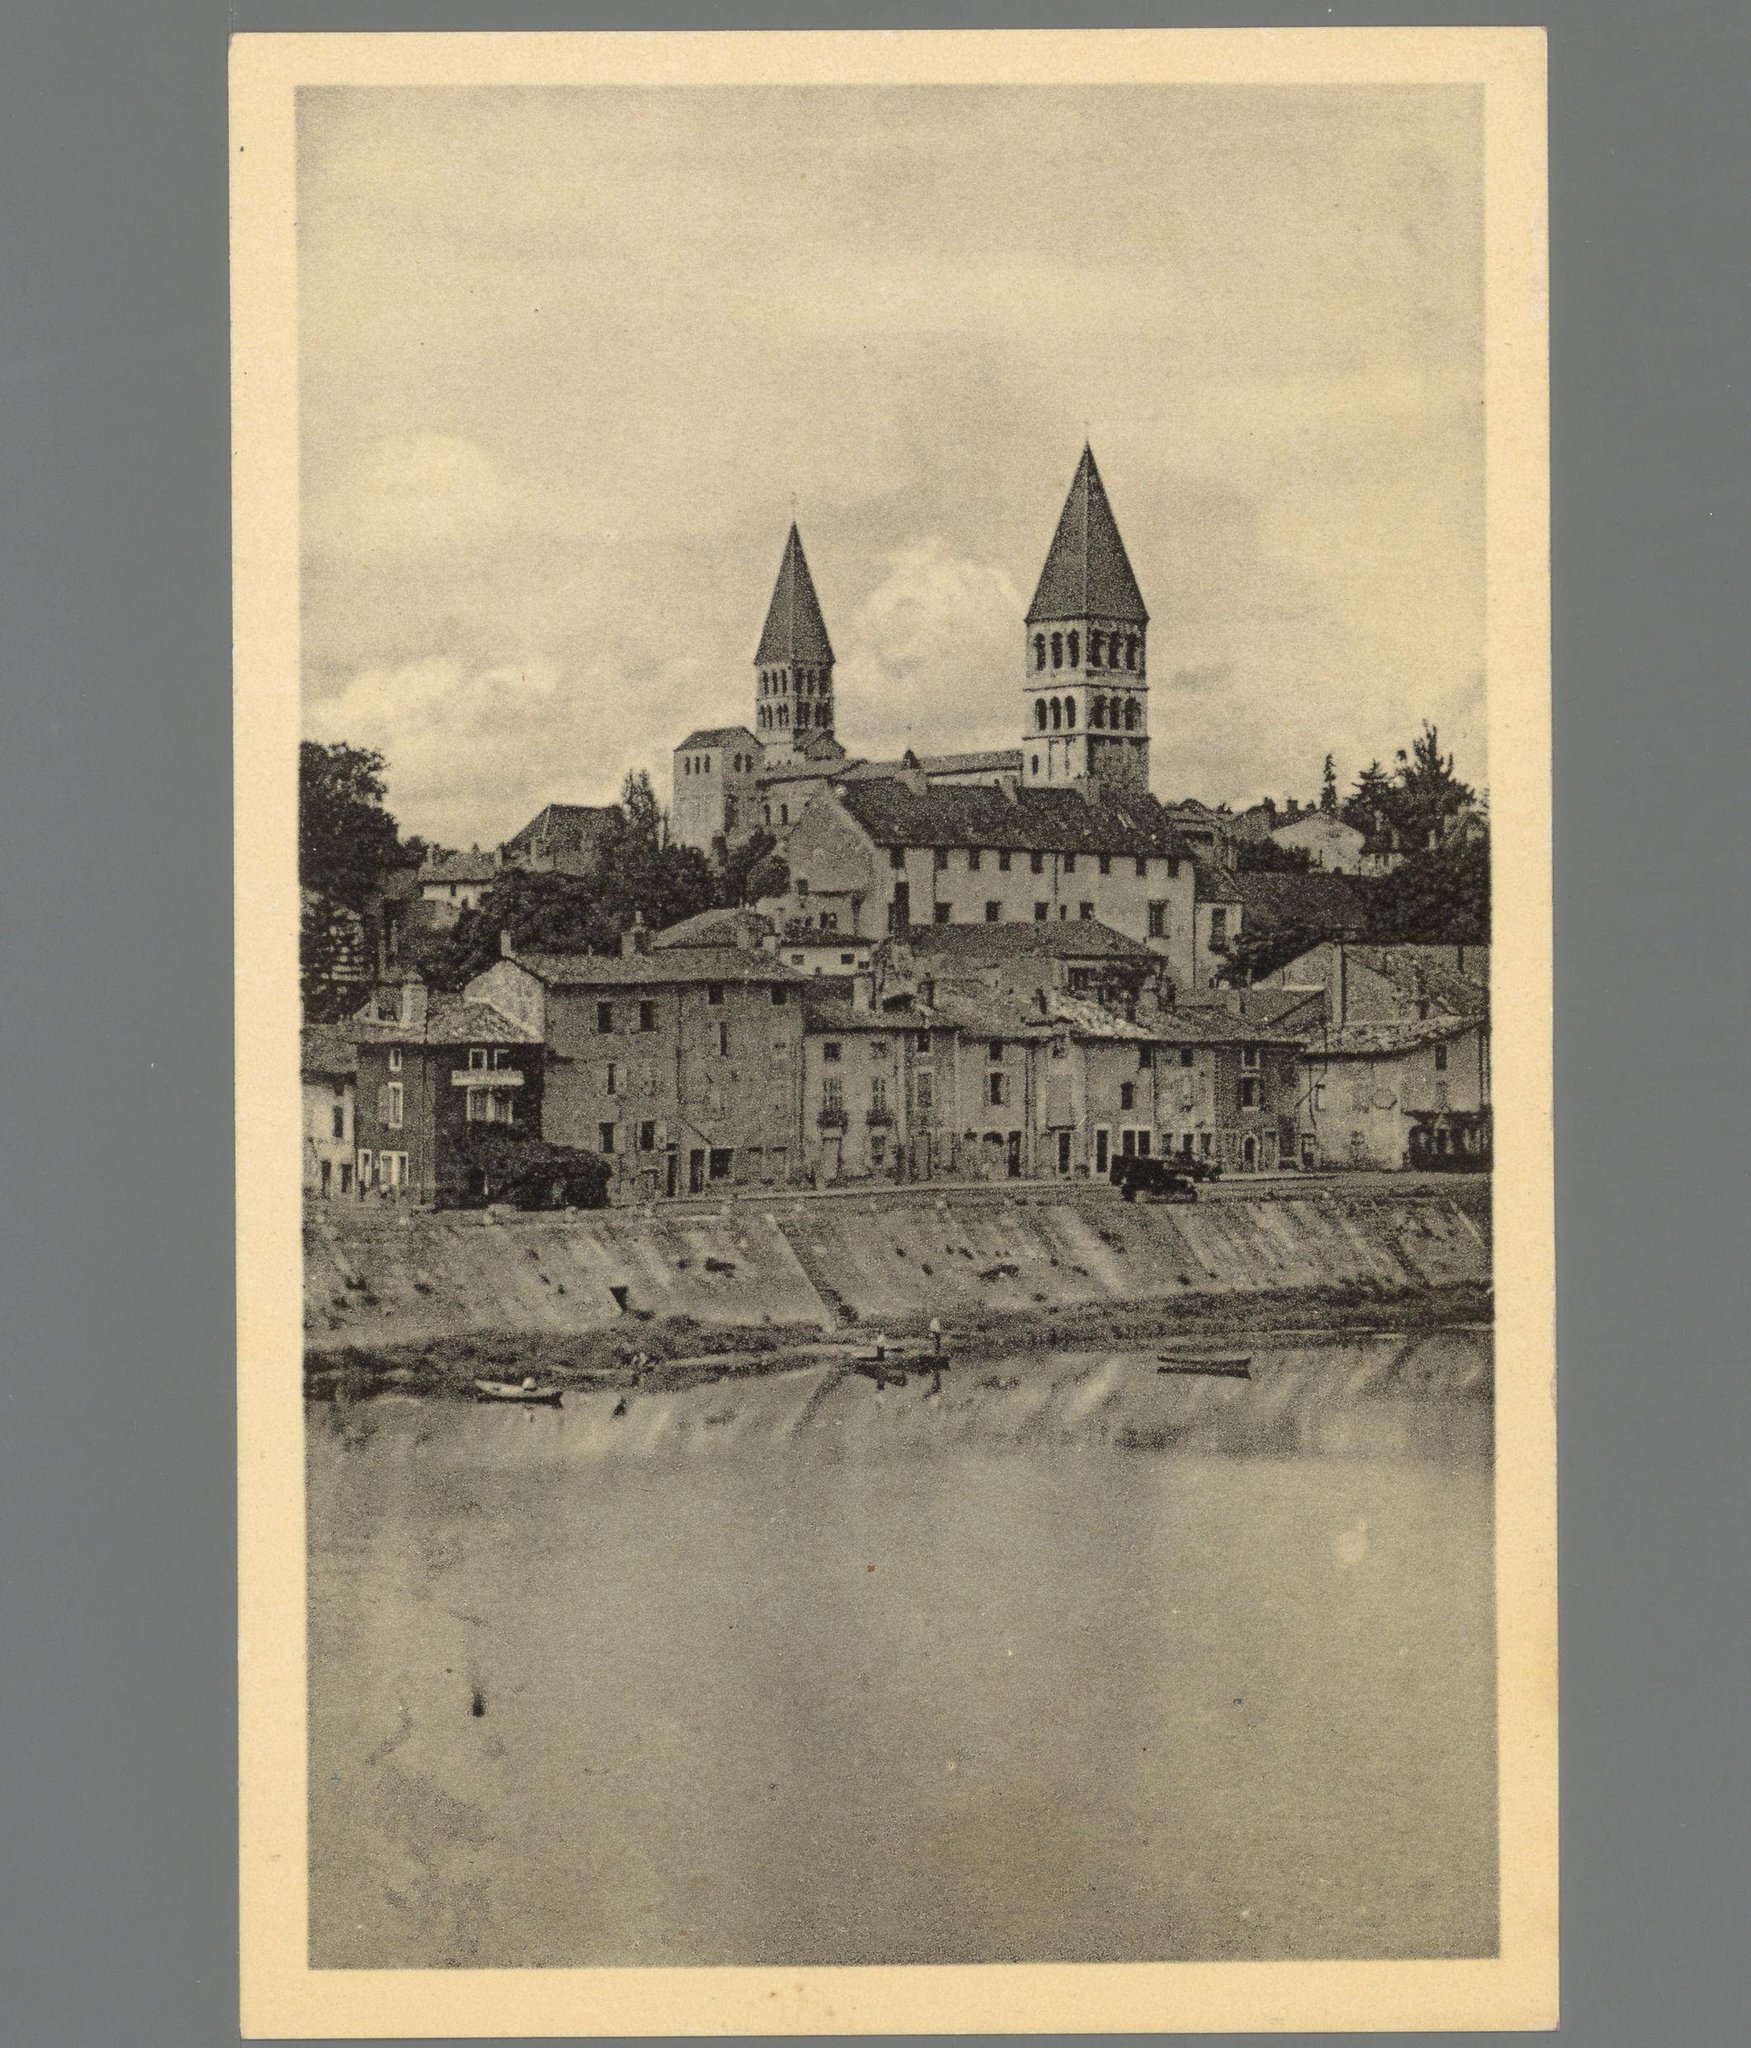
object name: photomechanical print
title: Tournus. L'Abbaye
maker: Anonymous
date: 1932-1940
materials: cardboard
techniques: photograph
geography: tournus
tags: abbey, monastery, convent ~ roman catholic church, church (exterior), city-view, and landscape with man-made constructions (+ city(-scape) with figures, staffage)